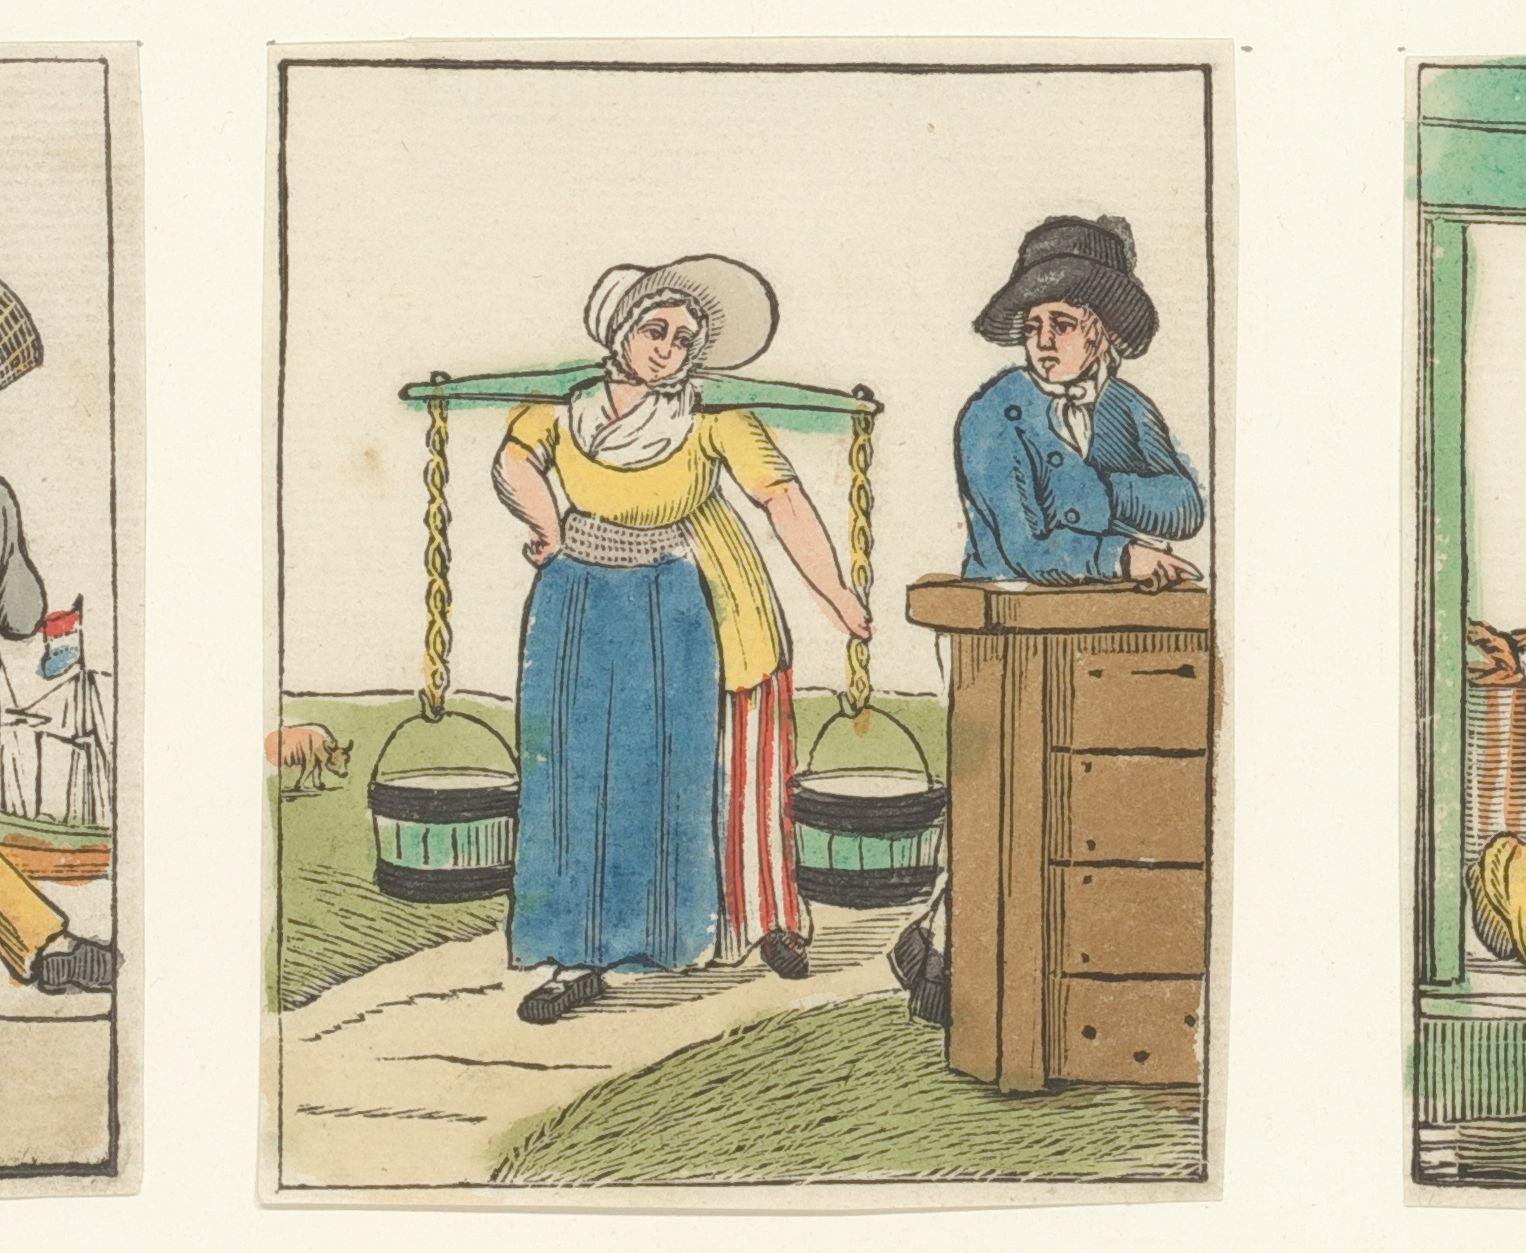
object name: print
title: Melkverkoopster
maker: Anonymous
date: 1827-1830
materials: paper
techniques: hand coloring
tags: milkmaid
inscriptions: collector's mark: Lugt 1641, stamp, collector's mark: Lugt 1641a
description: Prent waarschijnlijk uit: Nuttige en vermakelijke prentverbeeldingen: met ophelderende gesprekken, kleine raadsels en charaden. Rotterdam: T.J. WIjnhoven Hendriksen, 1830. Of een eerdere uitgave (1827).